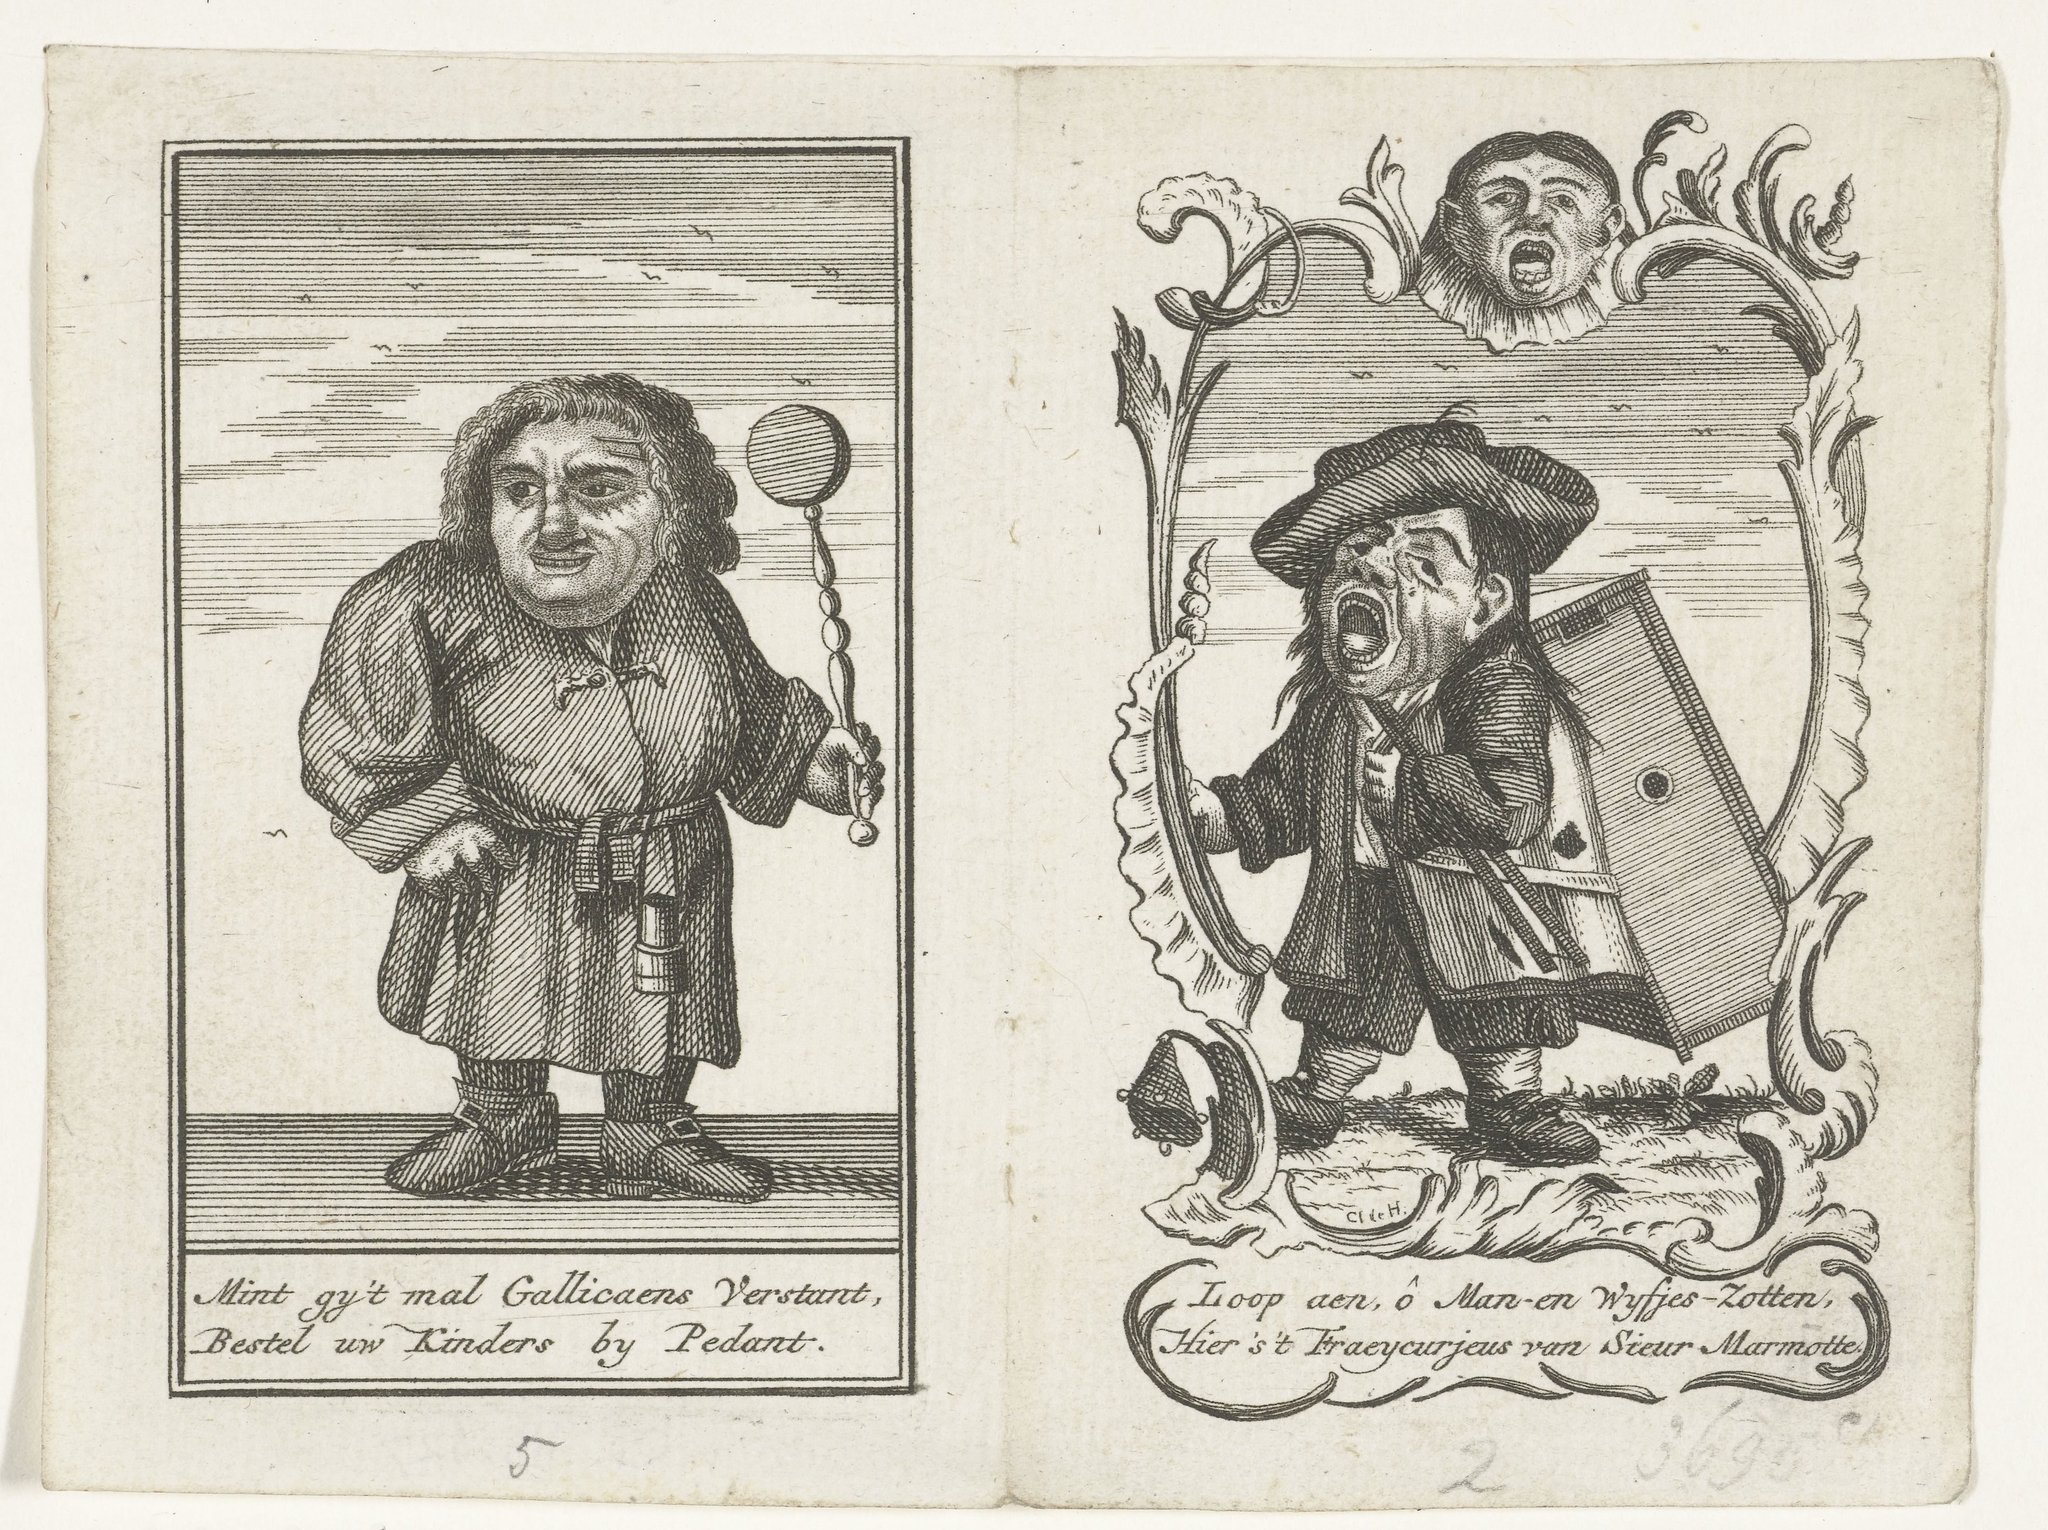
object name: caricature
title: Twee bladzijden met kleine mensen, ca. 1720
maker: Anonymous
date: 1770-1780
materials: paper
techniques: etching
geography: northern netherlands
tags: caricatures (human types), little people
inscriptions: collector's mark: Lugt 2228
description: Twee bladzijden met de kleine mensen Pedant en Sieur Marmotte, ca. 1720. Afkomstig uit een uitgave van ca. 1775 met verkleinde kopieën naar de oorspronkelijke Nederlandse serie met karikaturen van kleine mensen uit 1716, bekend als Het Dwergentooneel.